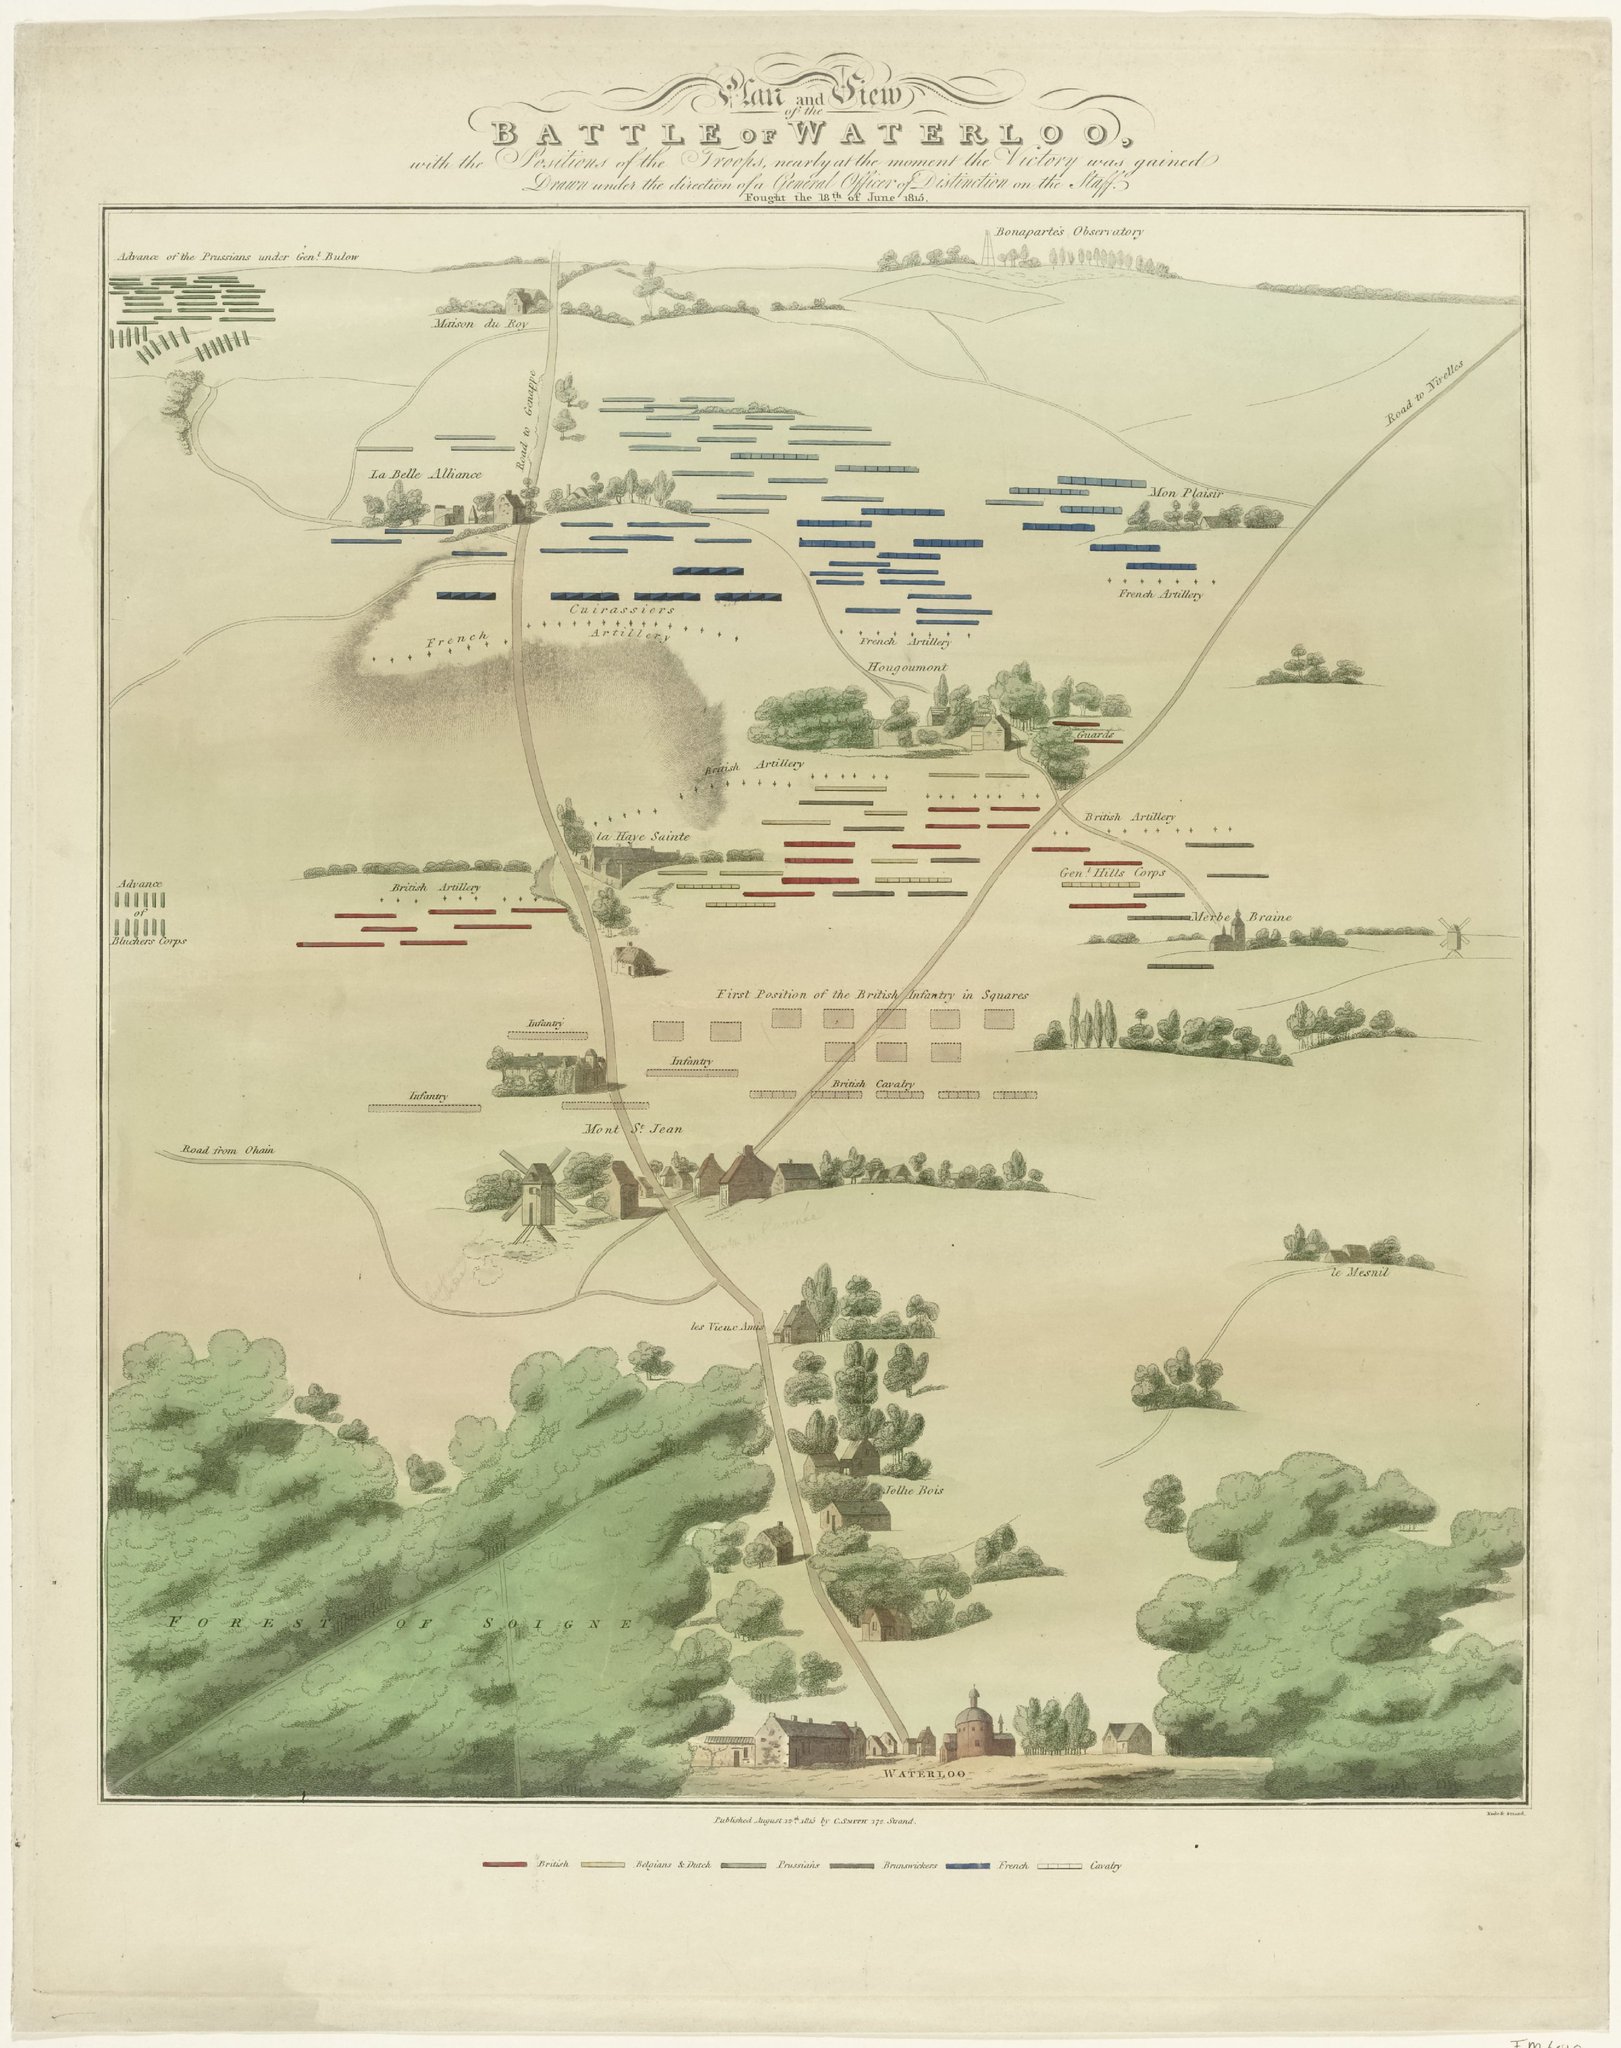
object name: print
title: Map and View of the Battle of Waterloo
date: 1815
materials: paper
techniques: etching, hand coloring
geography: england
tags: napoleon i (emperor of the french), battle (+ land forces), battle arrays, waterloo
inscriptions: collector's mark: Lugt 2228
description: This map was published two months after the victory over Napoleon. Different colours have been used to denote the opposing sides. The map’s orderly representation of the battlefield is misleading, for the bloody engagement was fought on a muddy terrain just eight square kilometres in size. After the battle large numbers of prints and maps were published to keep alive the memory of Waterloo.